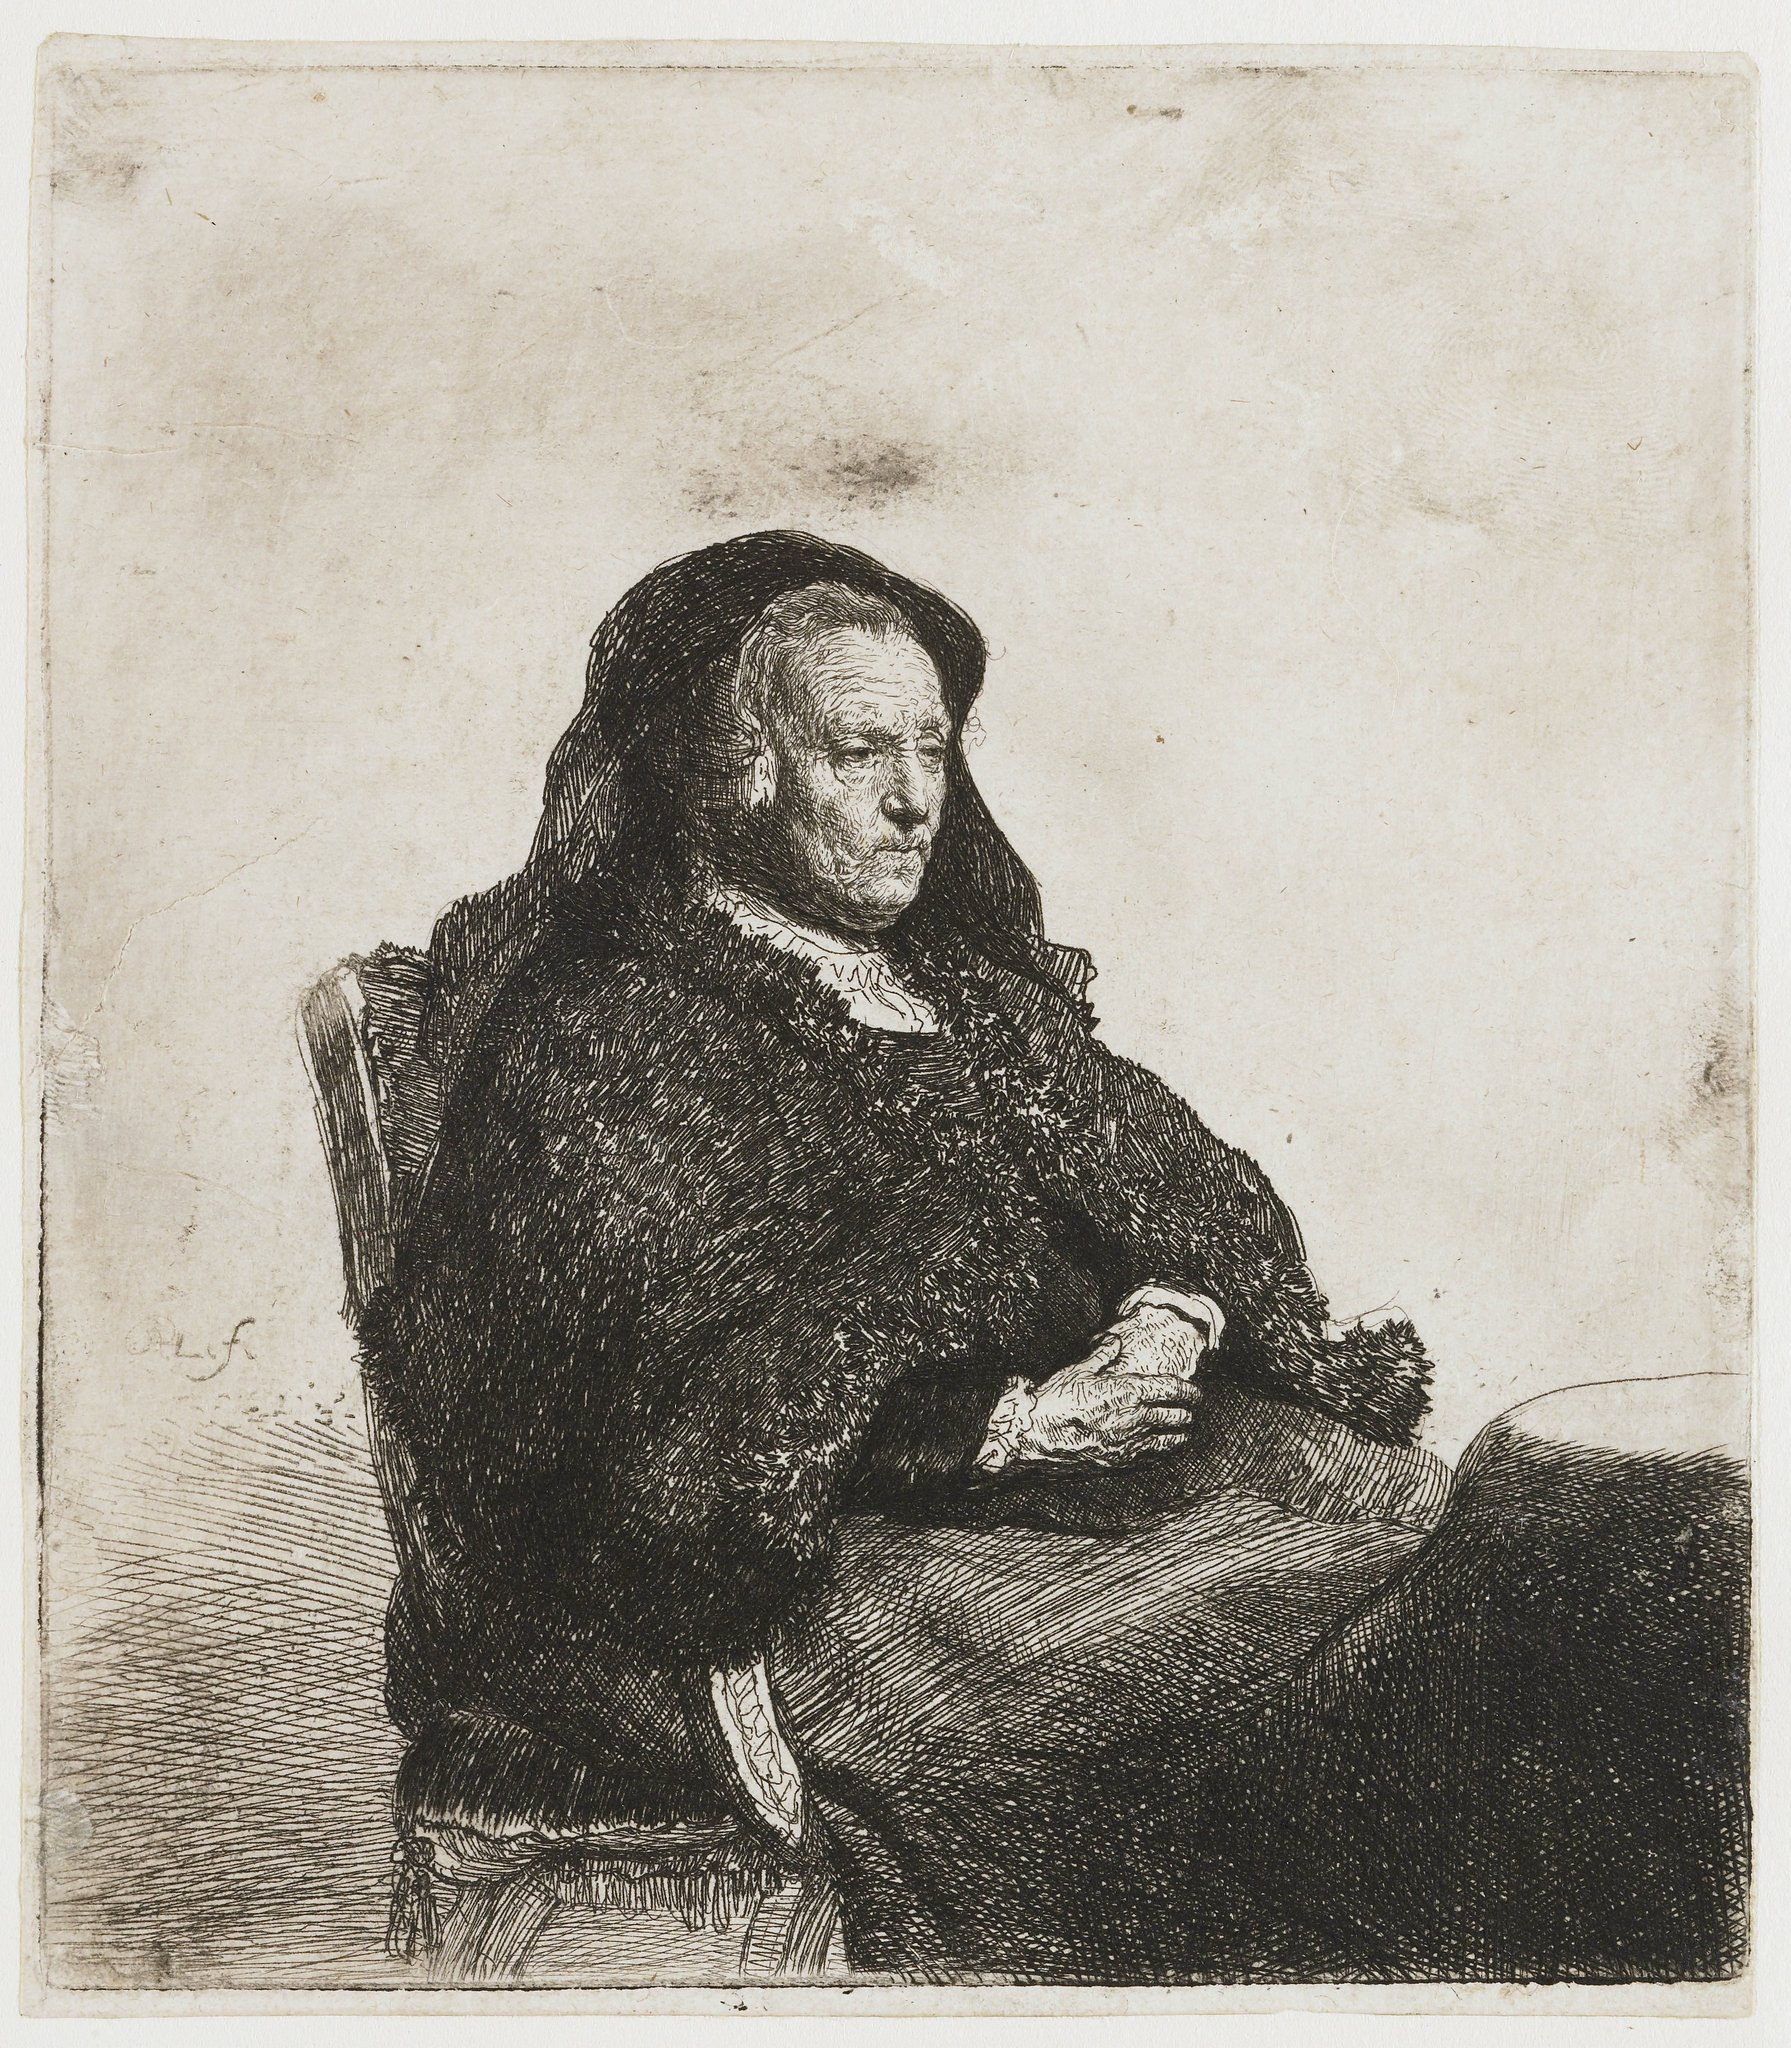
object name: print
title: The artist's mother seated at a table, looking right: three quarter length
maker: rembrandt van rijn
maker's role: draughtsman, painter, print maker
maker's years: 1606-1669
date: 1631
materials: paper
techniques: etching, intaglio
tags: neeltje willemsdr. zuytbrouck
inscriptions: collector's mark: Lugt 240, monogram: ‘RHL f’